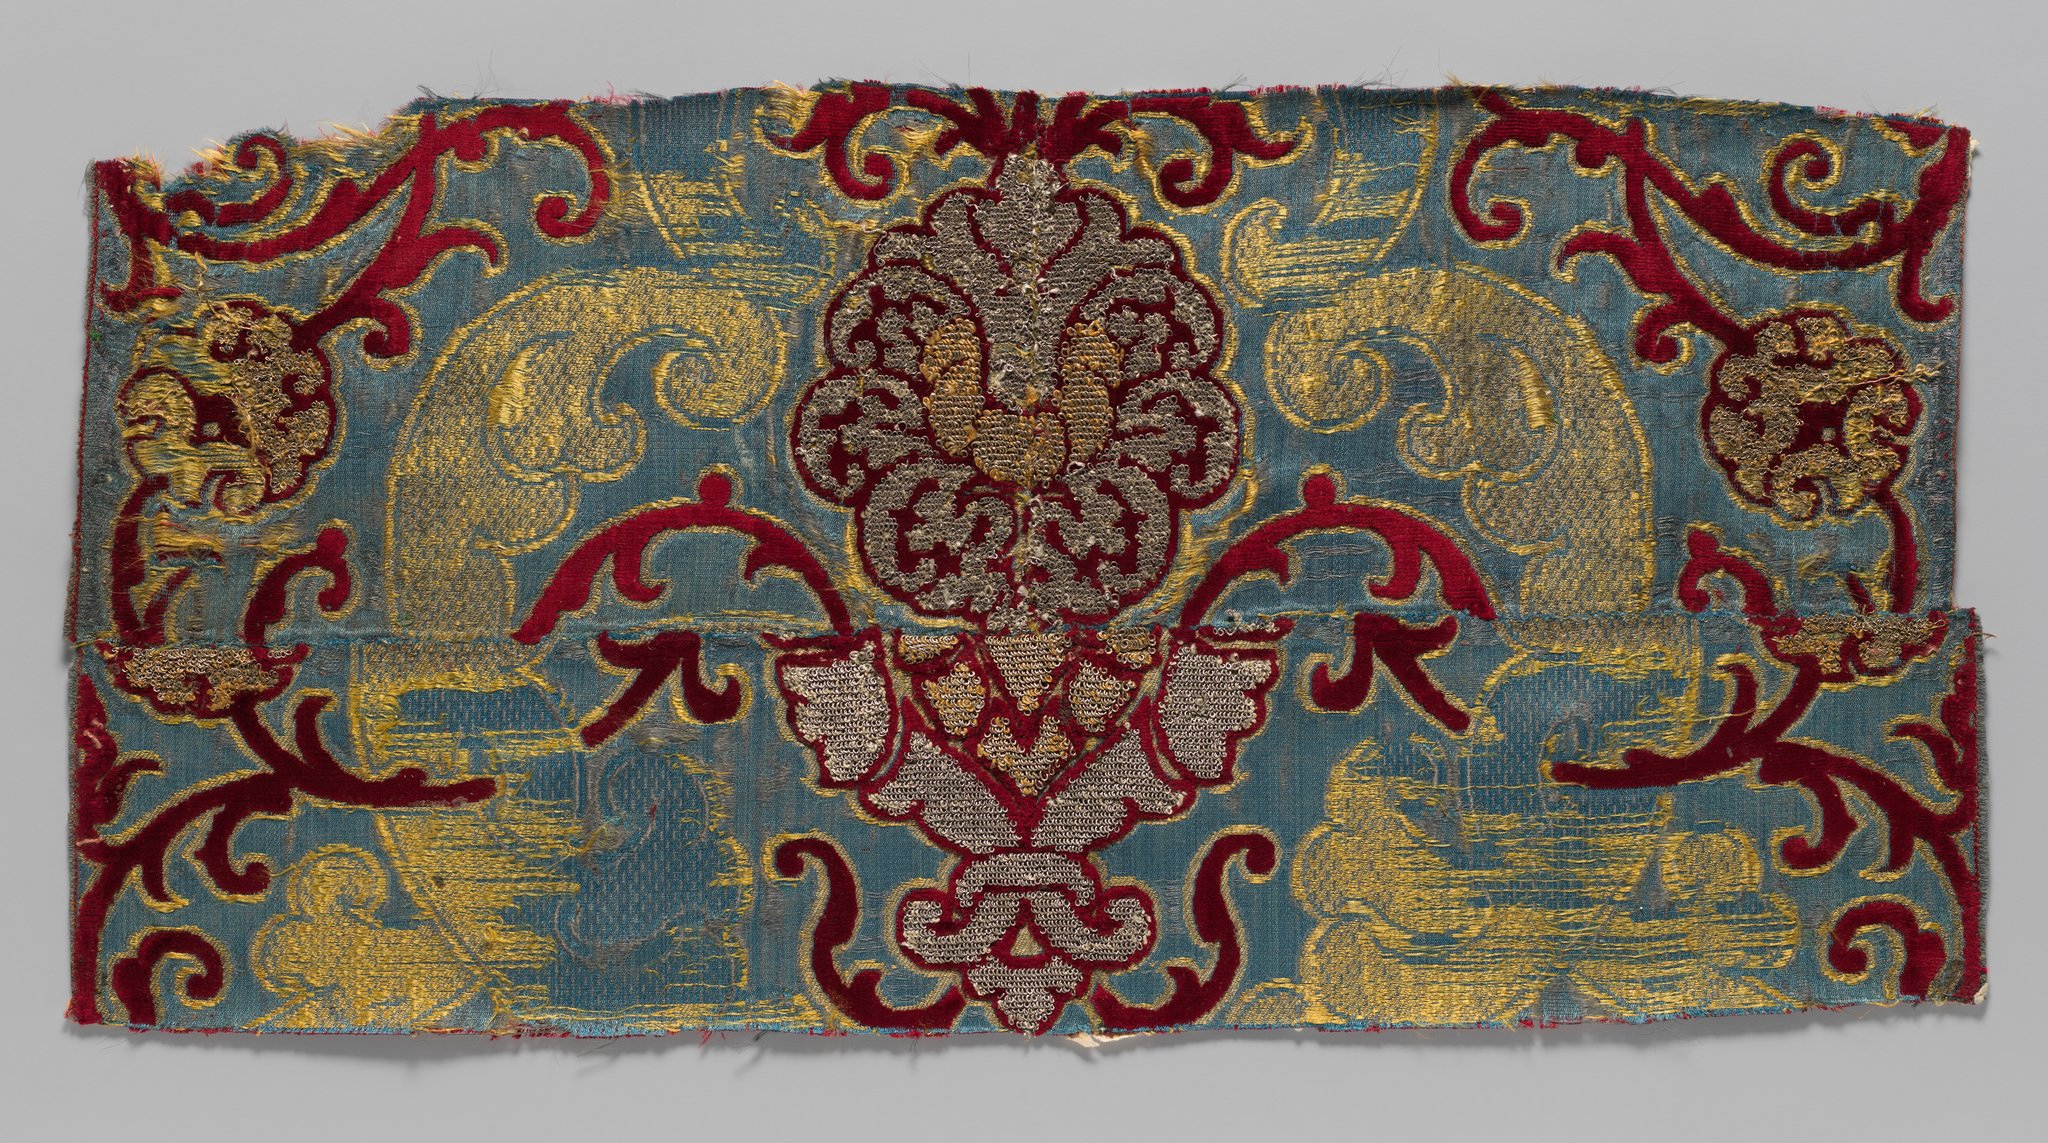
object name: fragment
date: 1501-1600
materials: metal thread, silk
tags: flowers